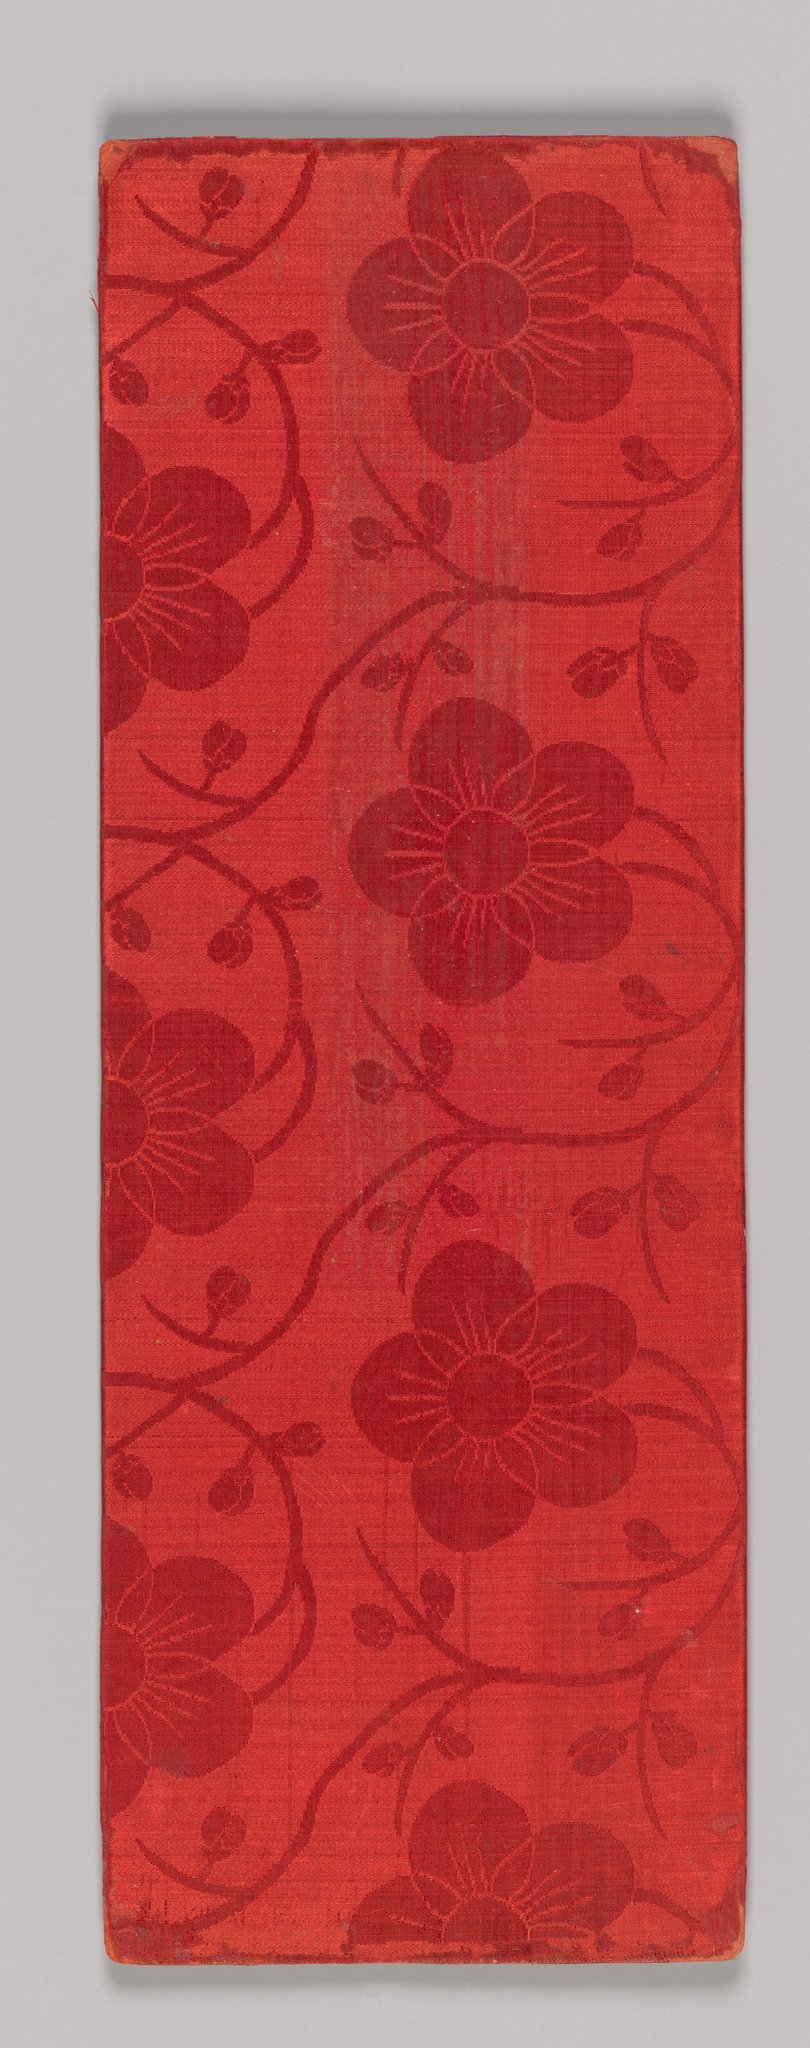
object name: sutra cover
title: Sutra Cover with Prunus Scroll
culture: chinese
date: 1501-1600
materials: silk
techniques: damask